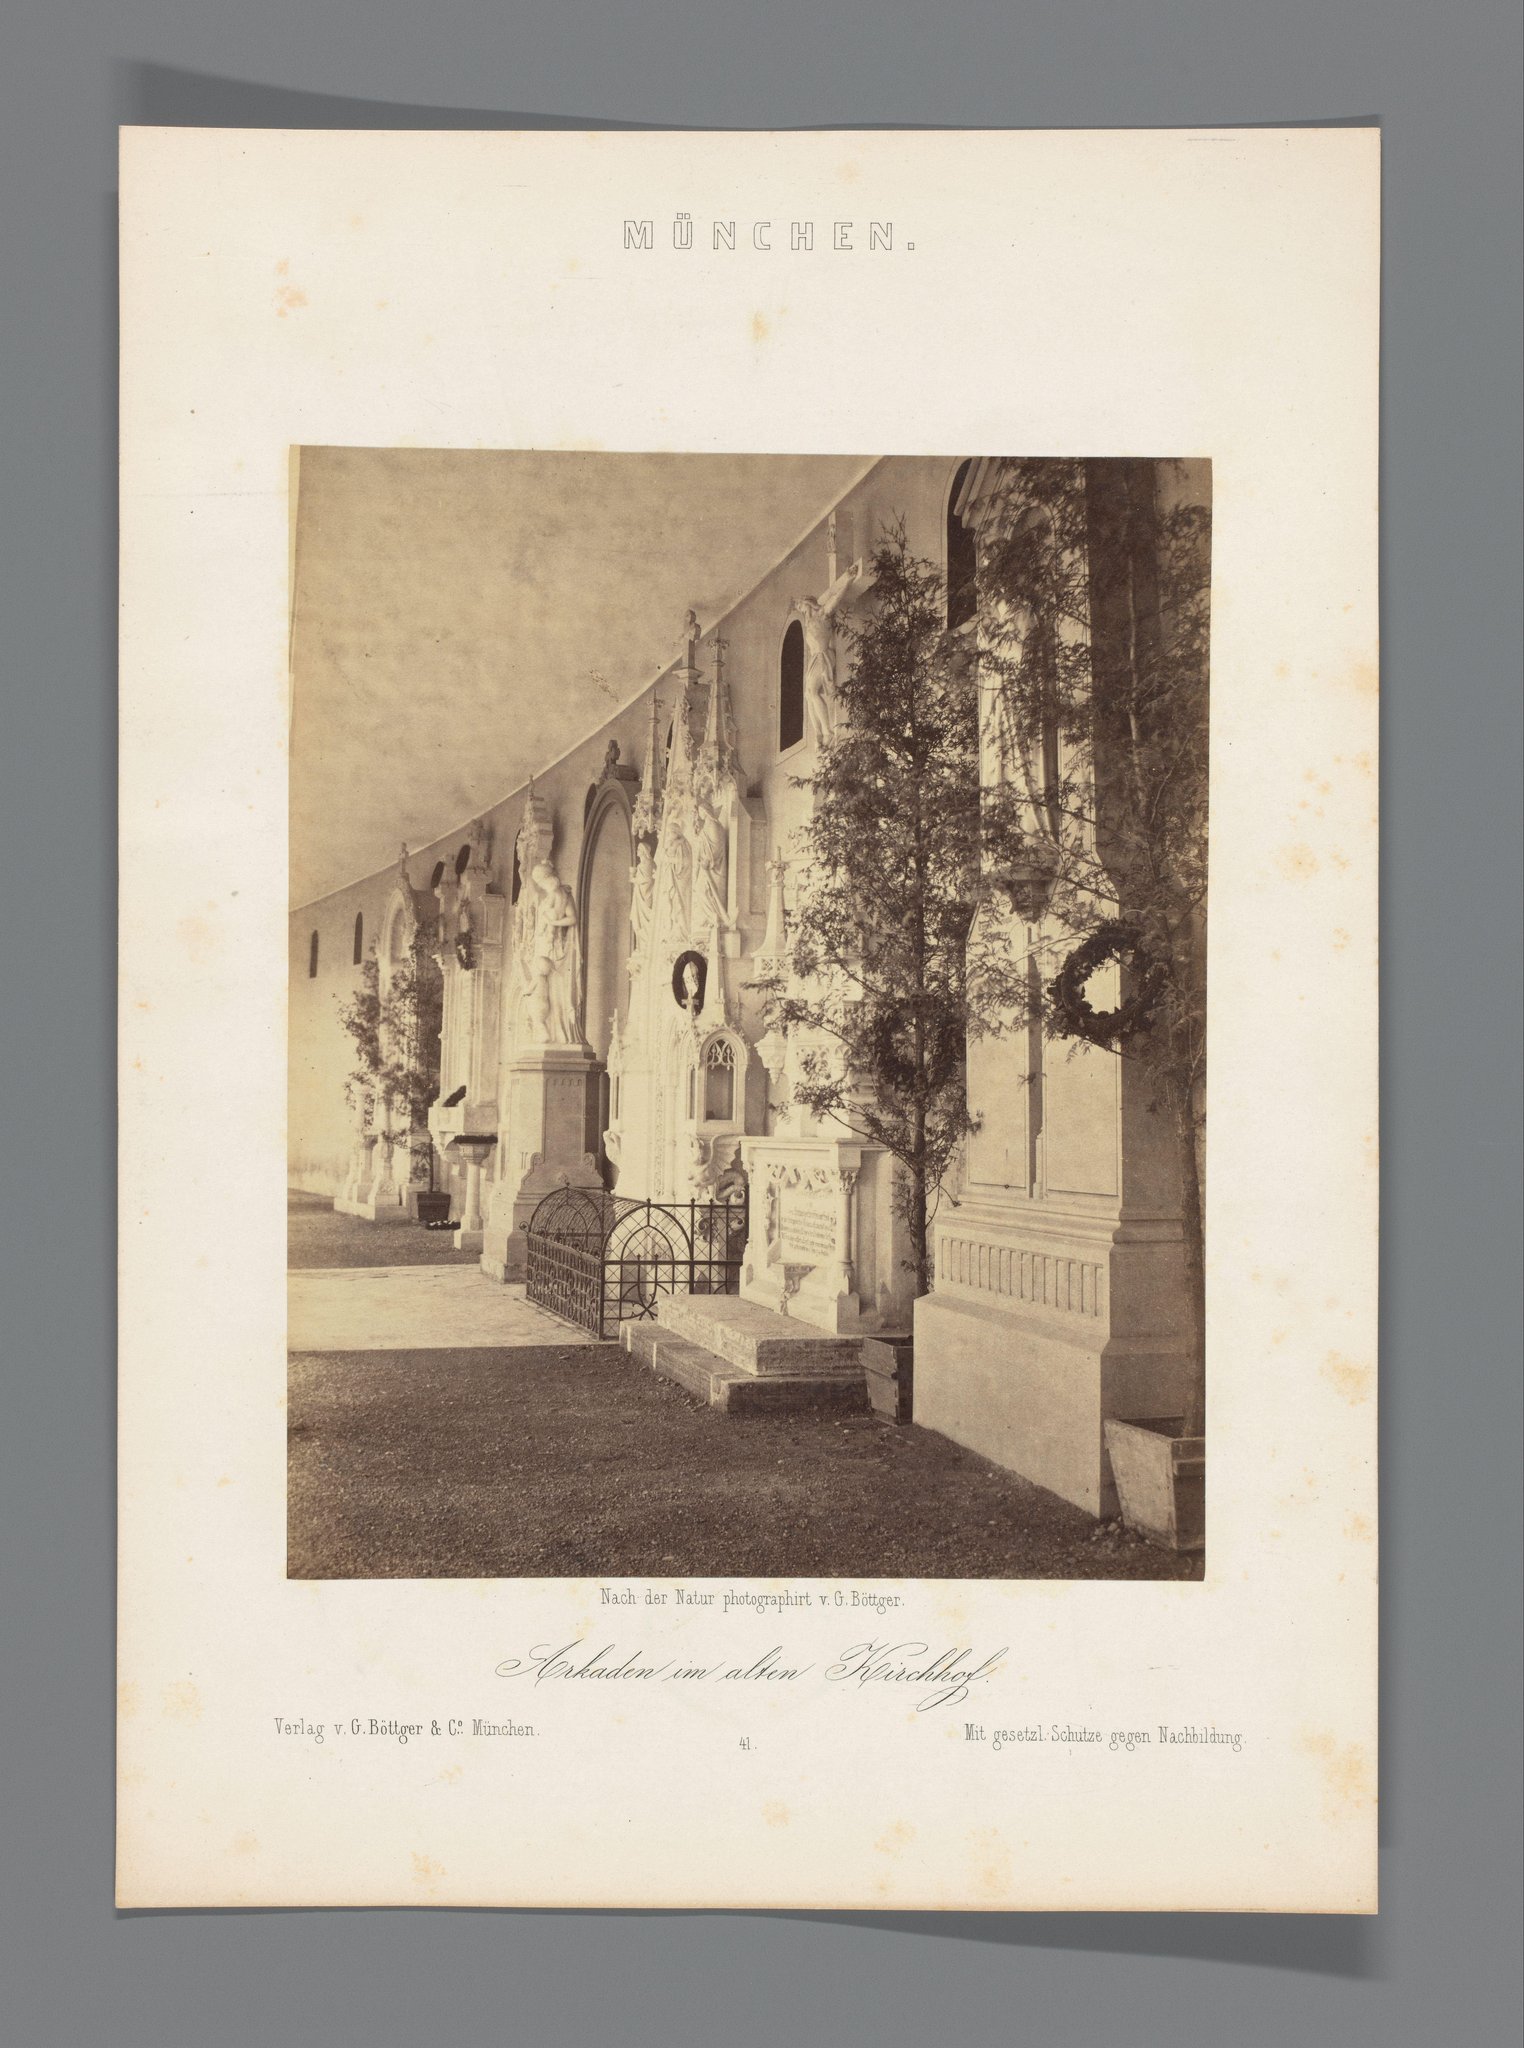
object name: photograph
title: München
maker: Anonymous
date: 1850-1900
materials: paper, photographic support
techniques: albumen print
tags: münchen